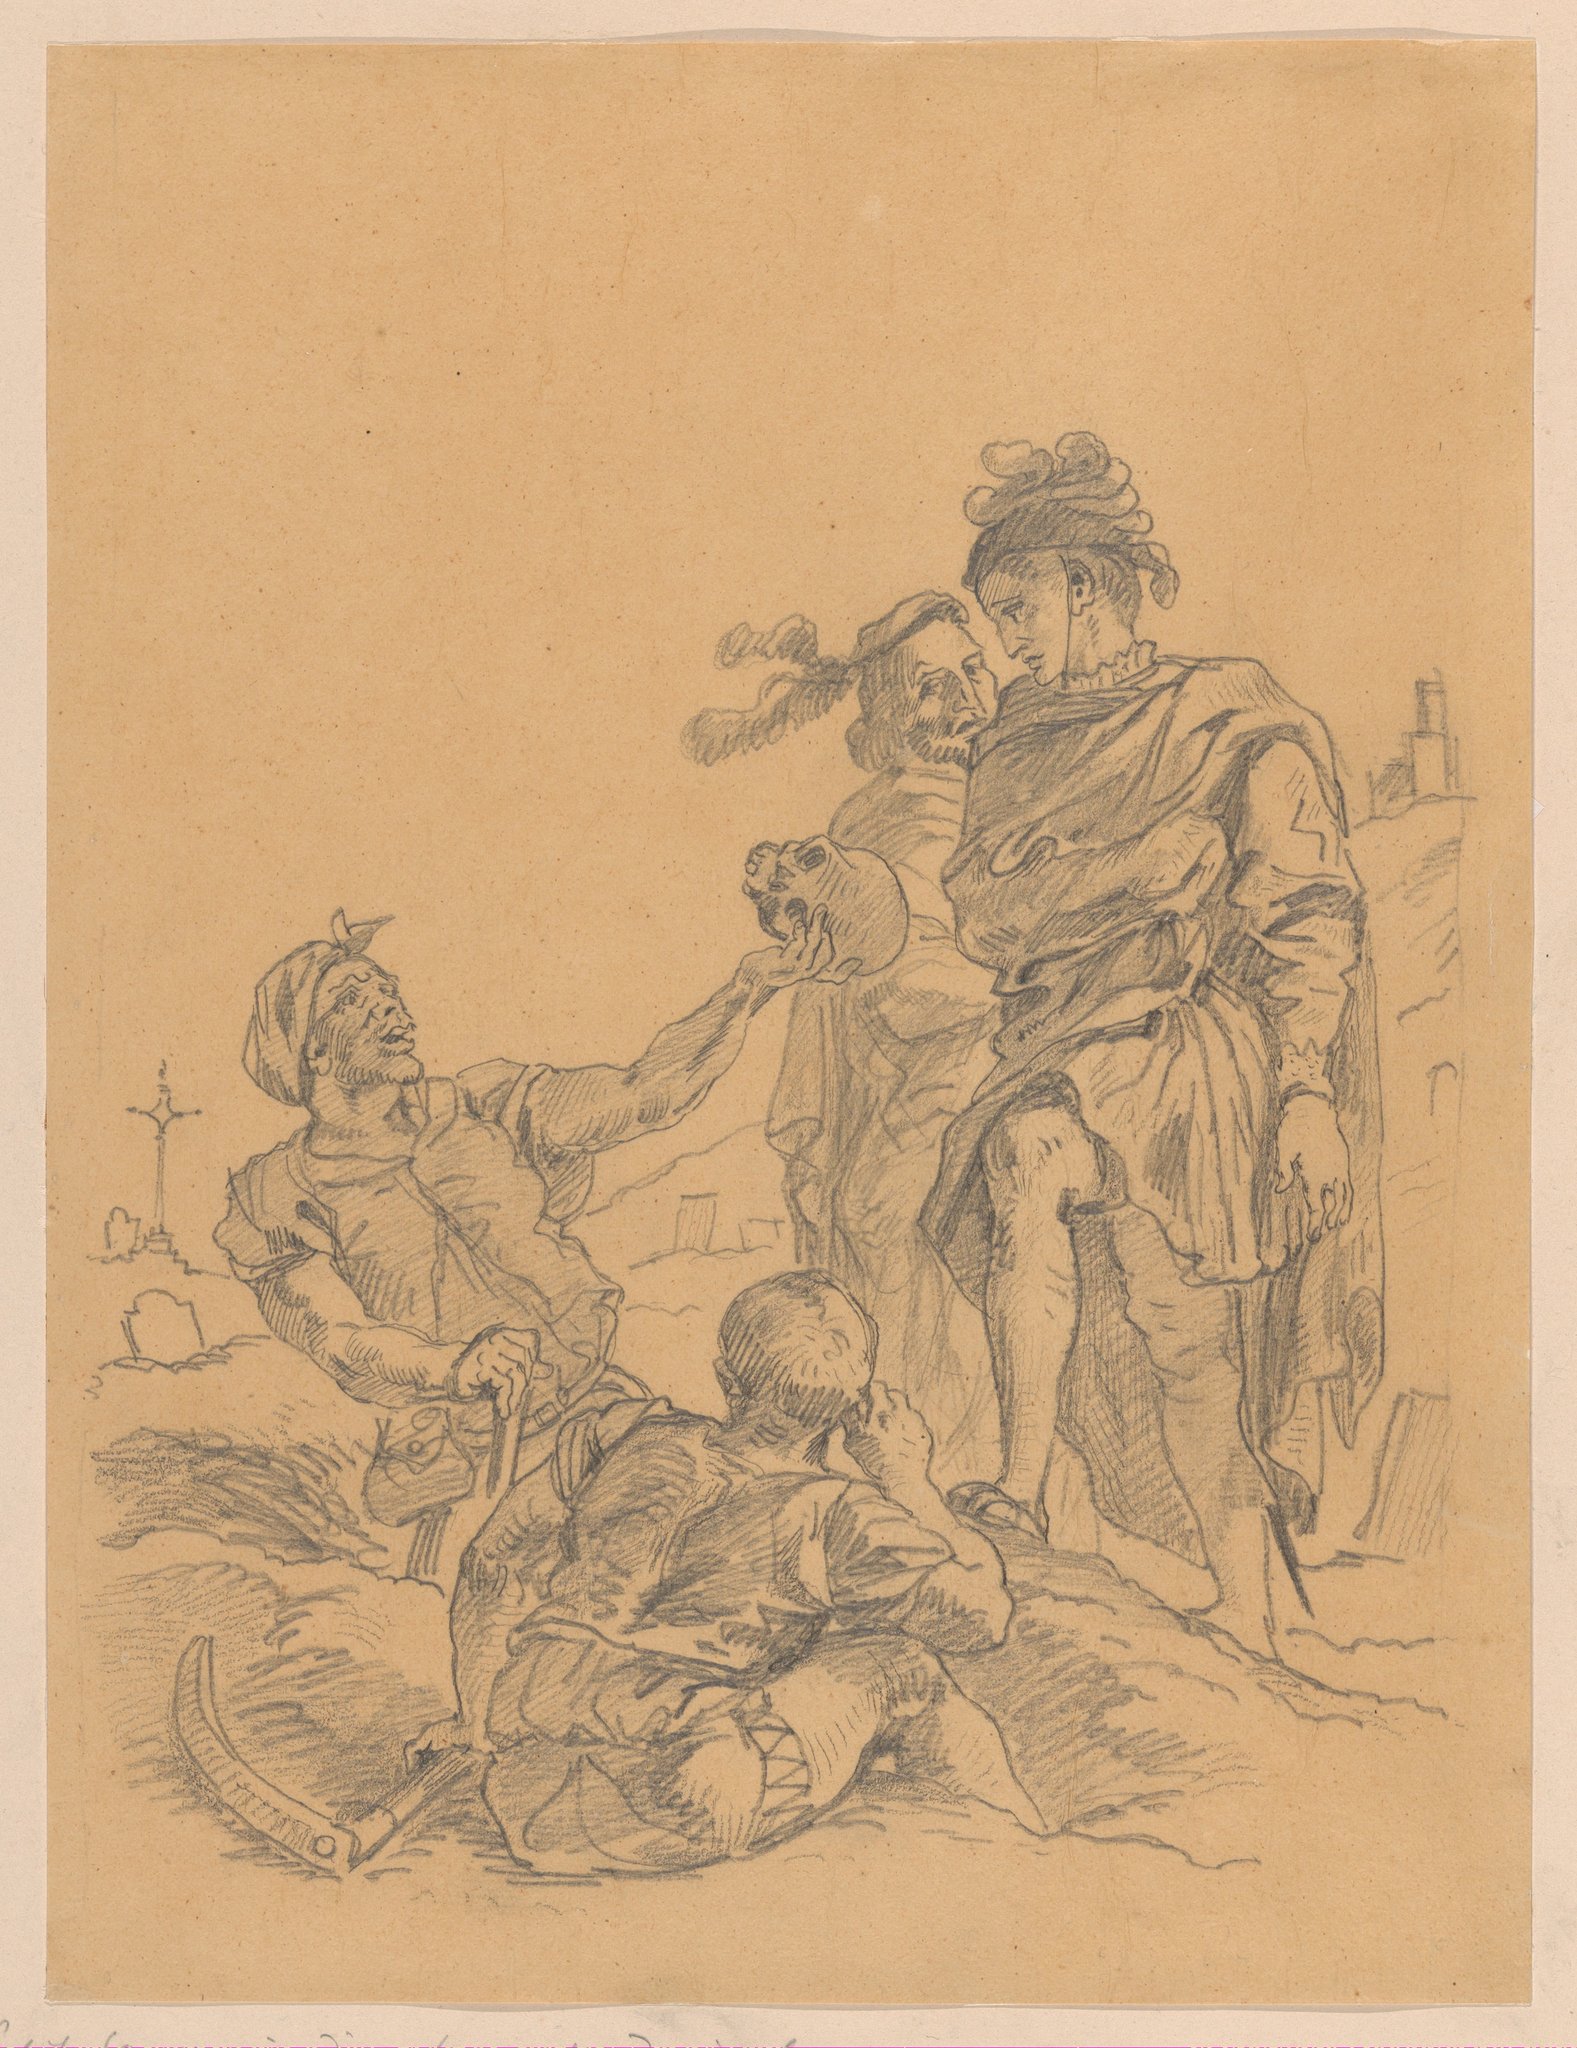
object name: drawing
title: Alas! Poor Yorick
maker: eugène delacroix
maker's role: artist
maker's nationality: french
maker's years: 1798-1863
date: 1843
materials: graphite